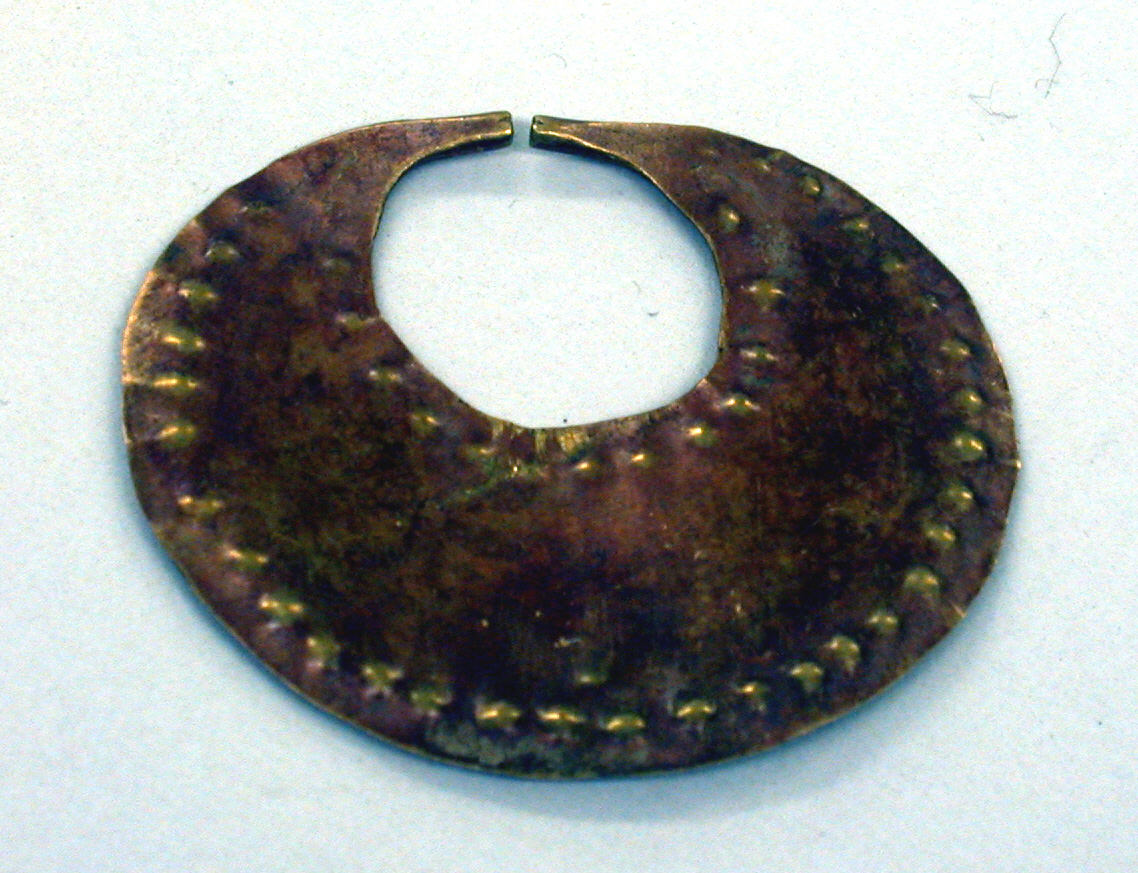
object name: nose ornament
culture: moche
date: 501-700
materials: gold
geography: peru